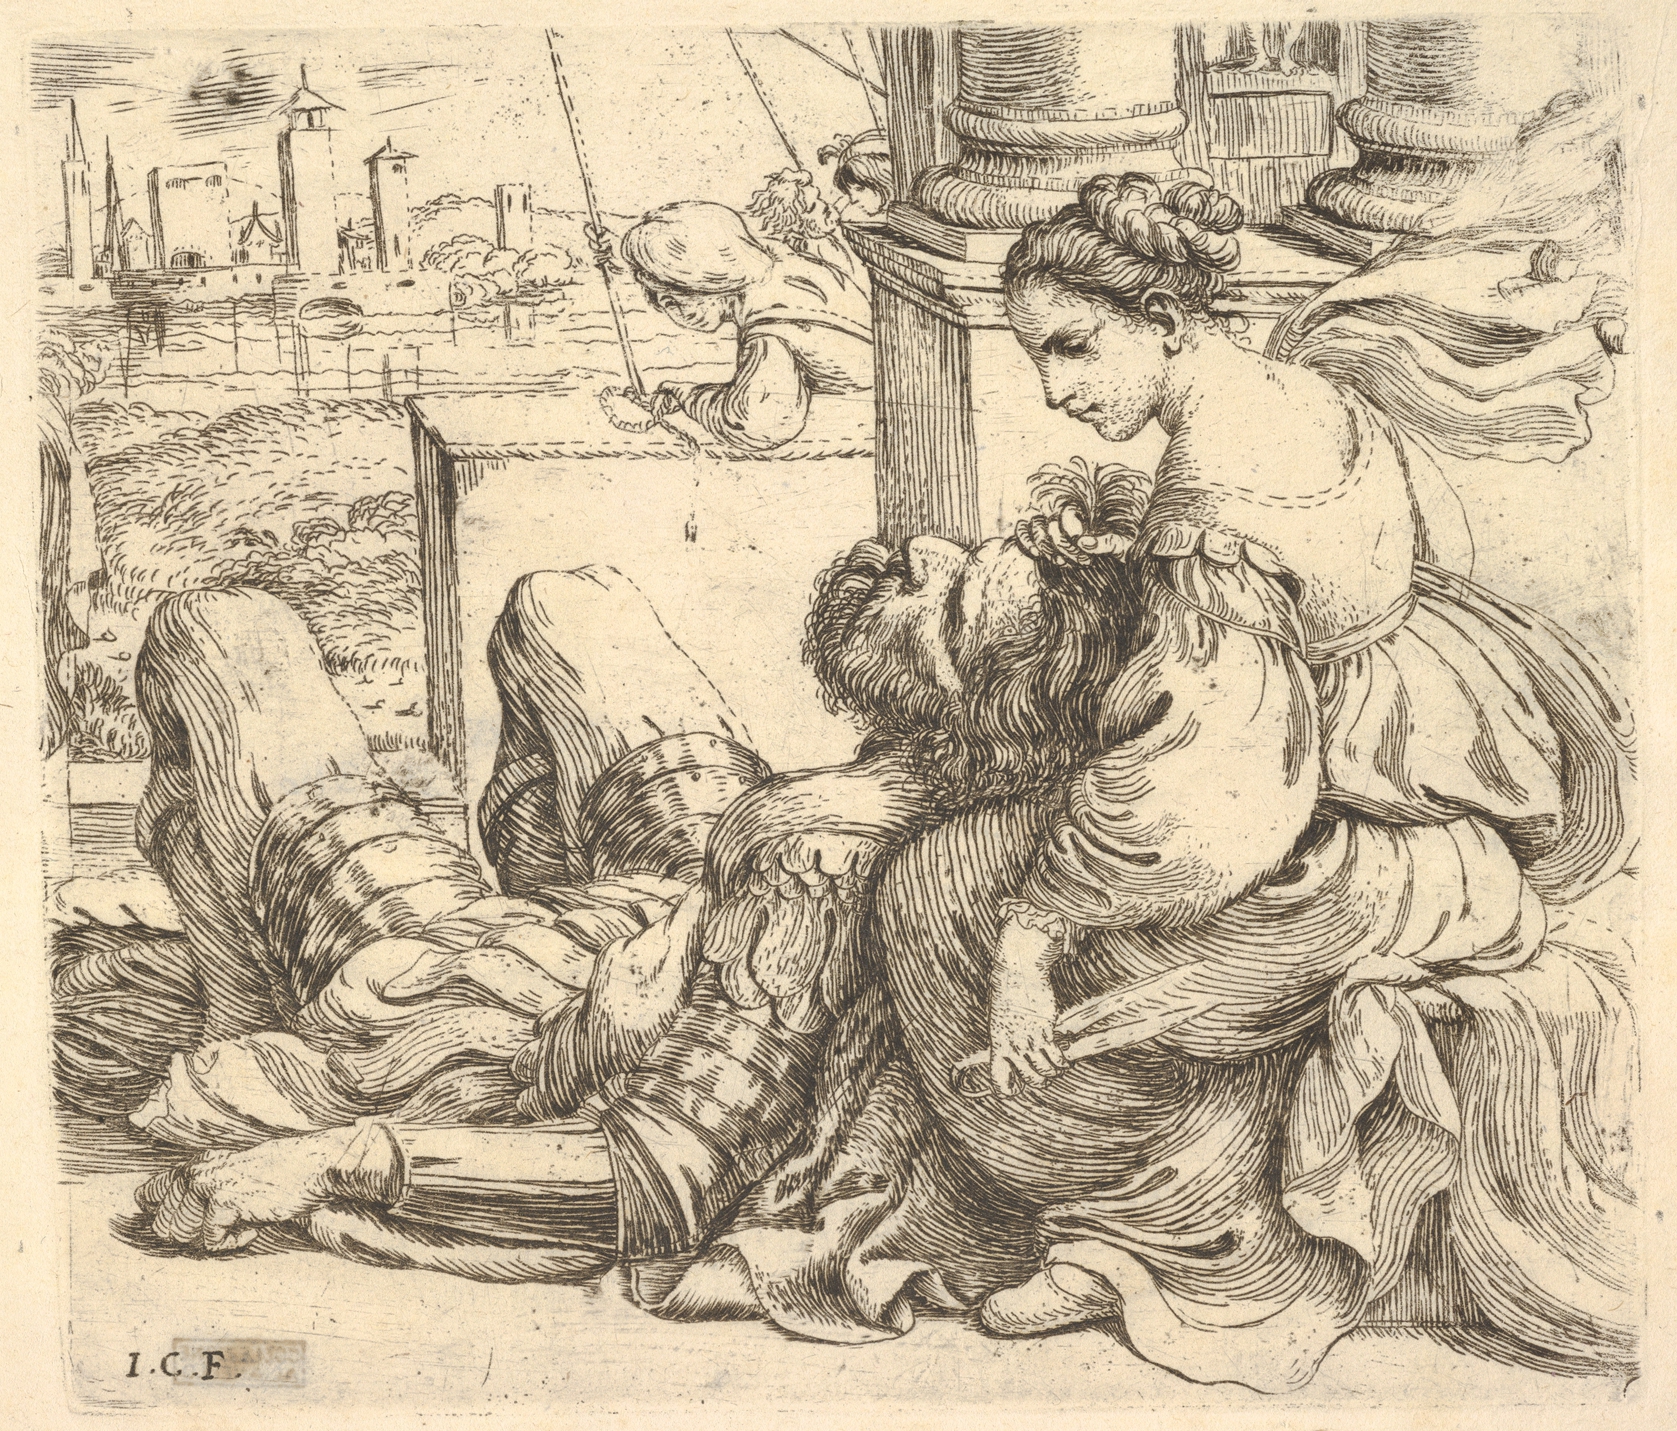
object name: print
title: Delilah holding Samson's hair and a pair of scissors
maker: giuseppe caletti, called cremonese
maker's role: artist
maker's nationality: italian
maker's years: 1600-1660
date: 1620-1630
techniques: etching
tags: women,samson